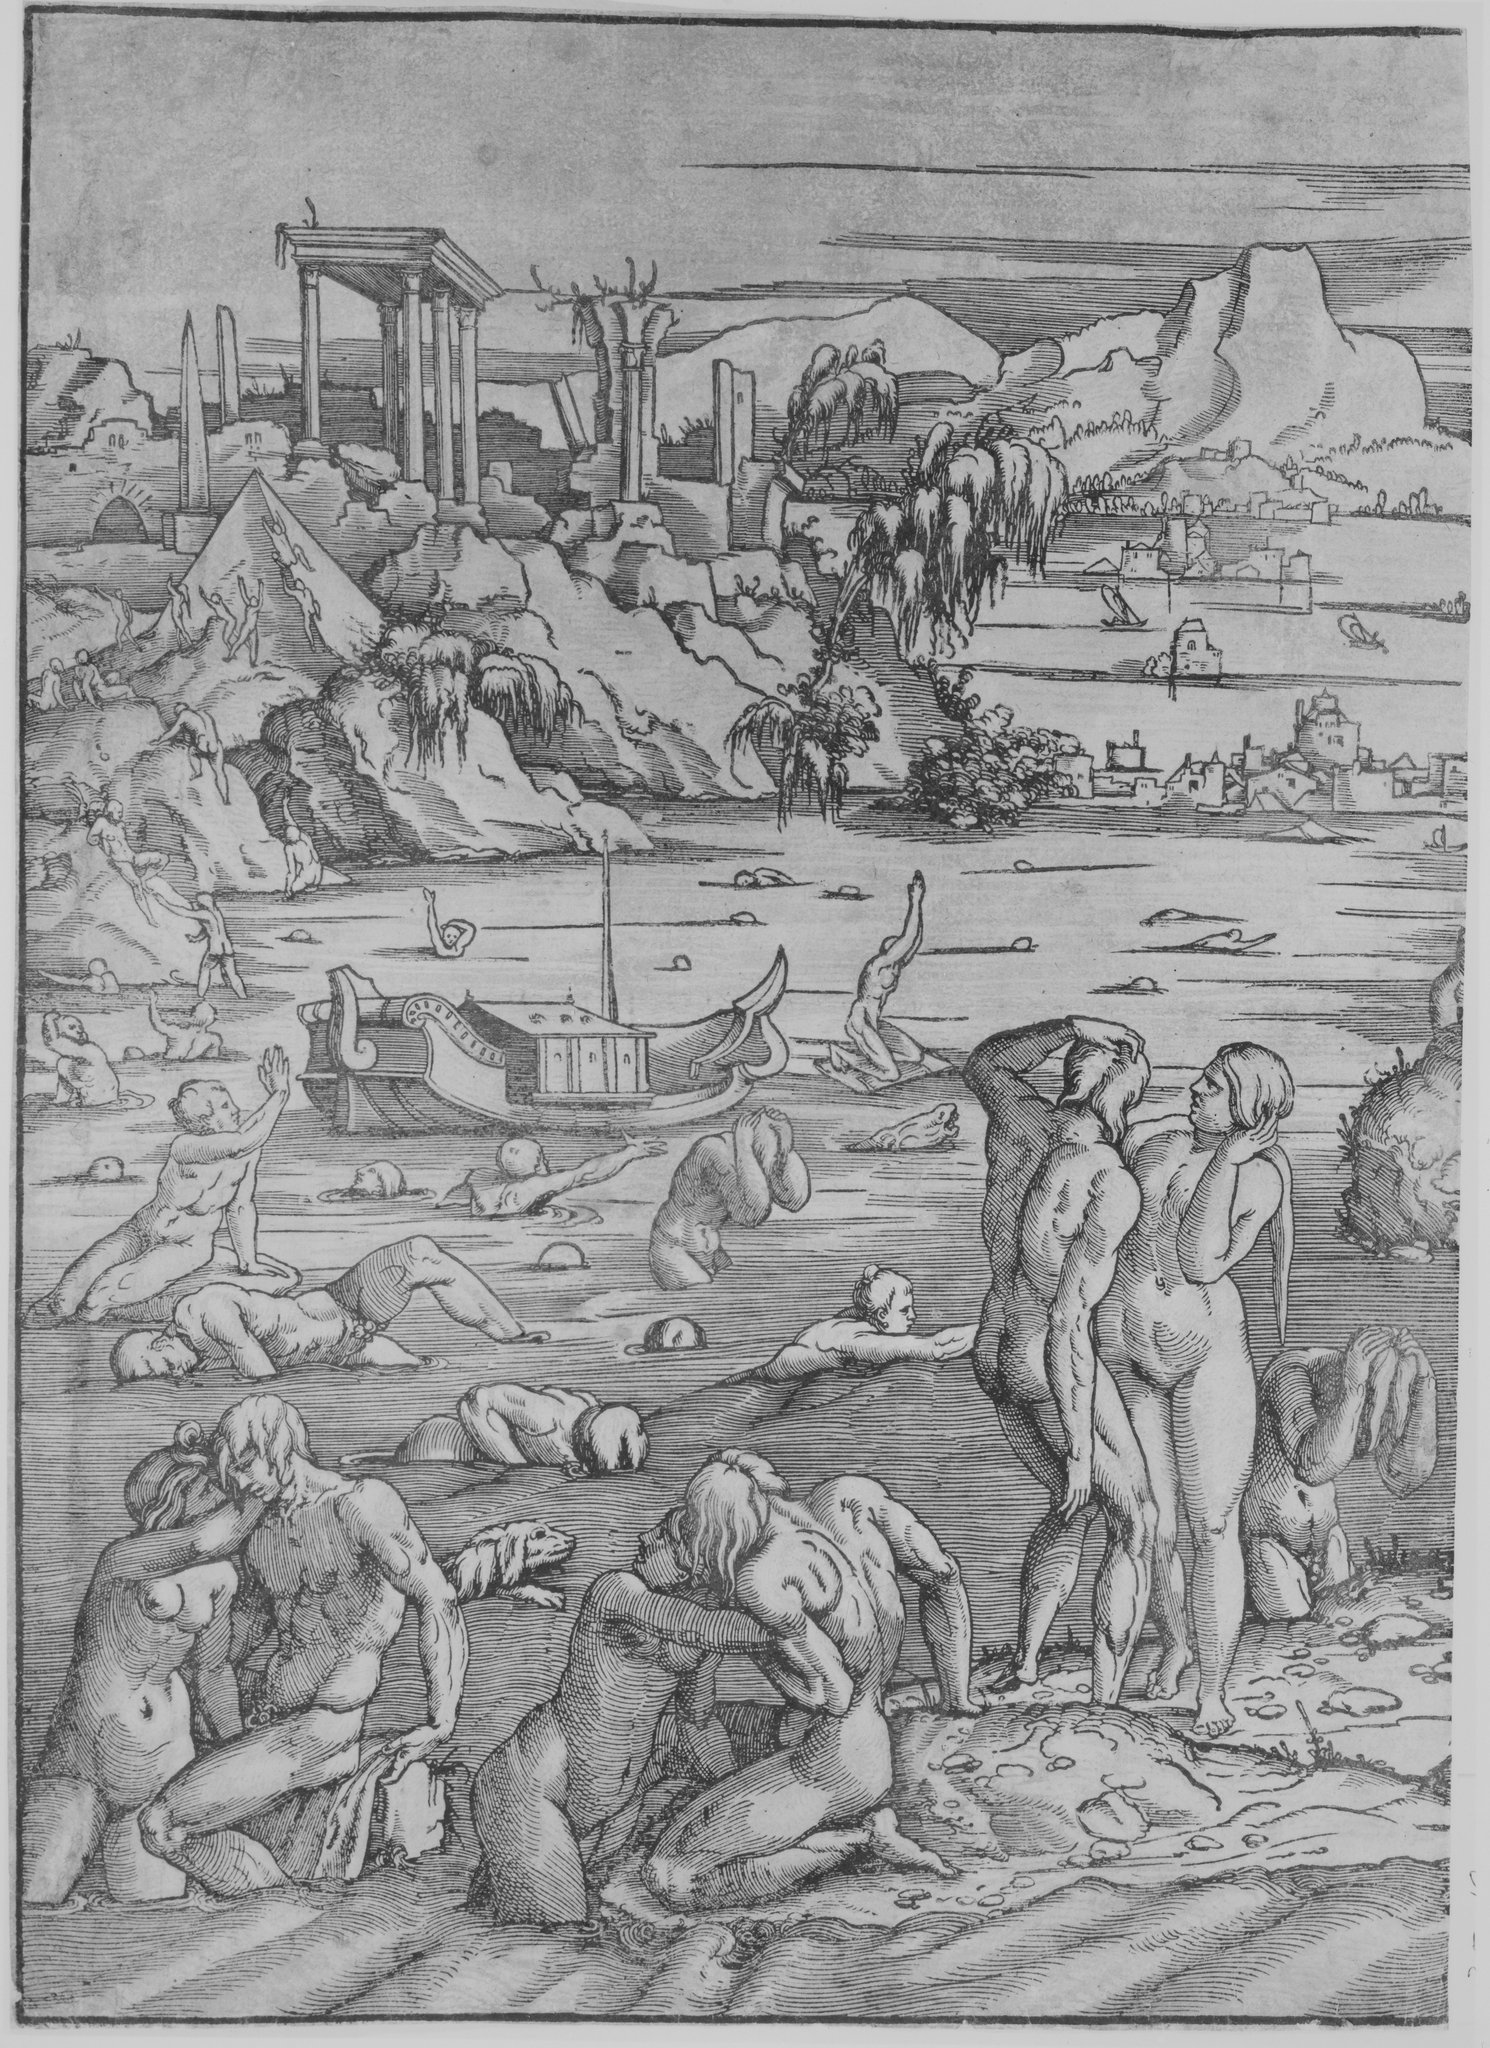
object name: print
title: The Deluge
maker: jan van scorel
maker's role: artist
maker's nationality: netherlandish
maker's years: 1495-1562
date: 1524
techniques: hand coloring, printing, woodcut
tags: male nudes,female nudes,floods,boats